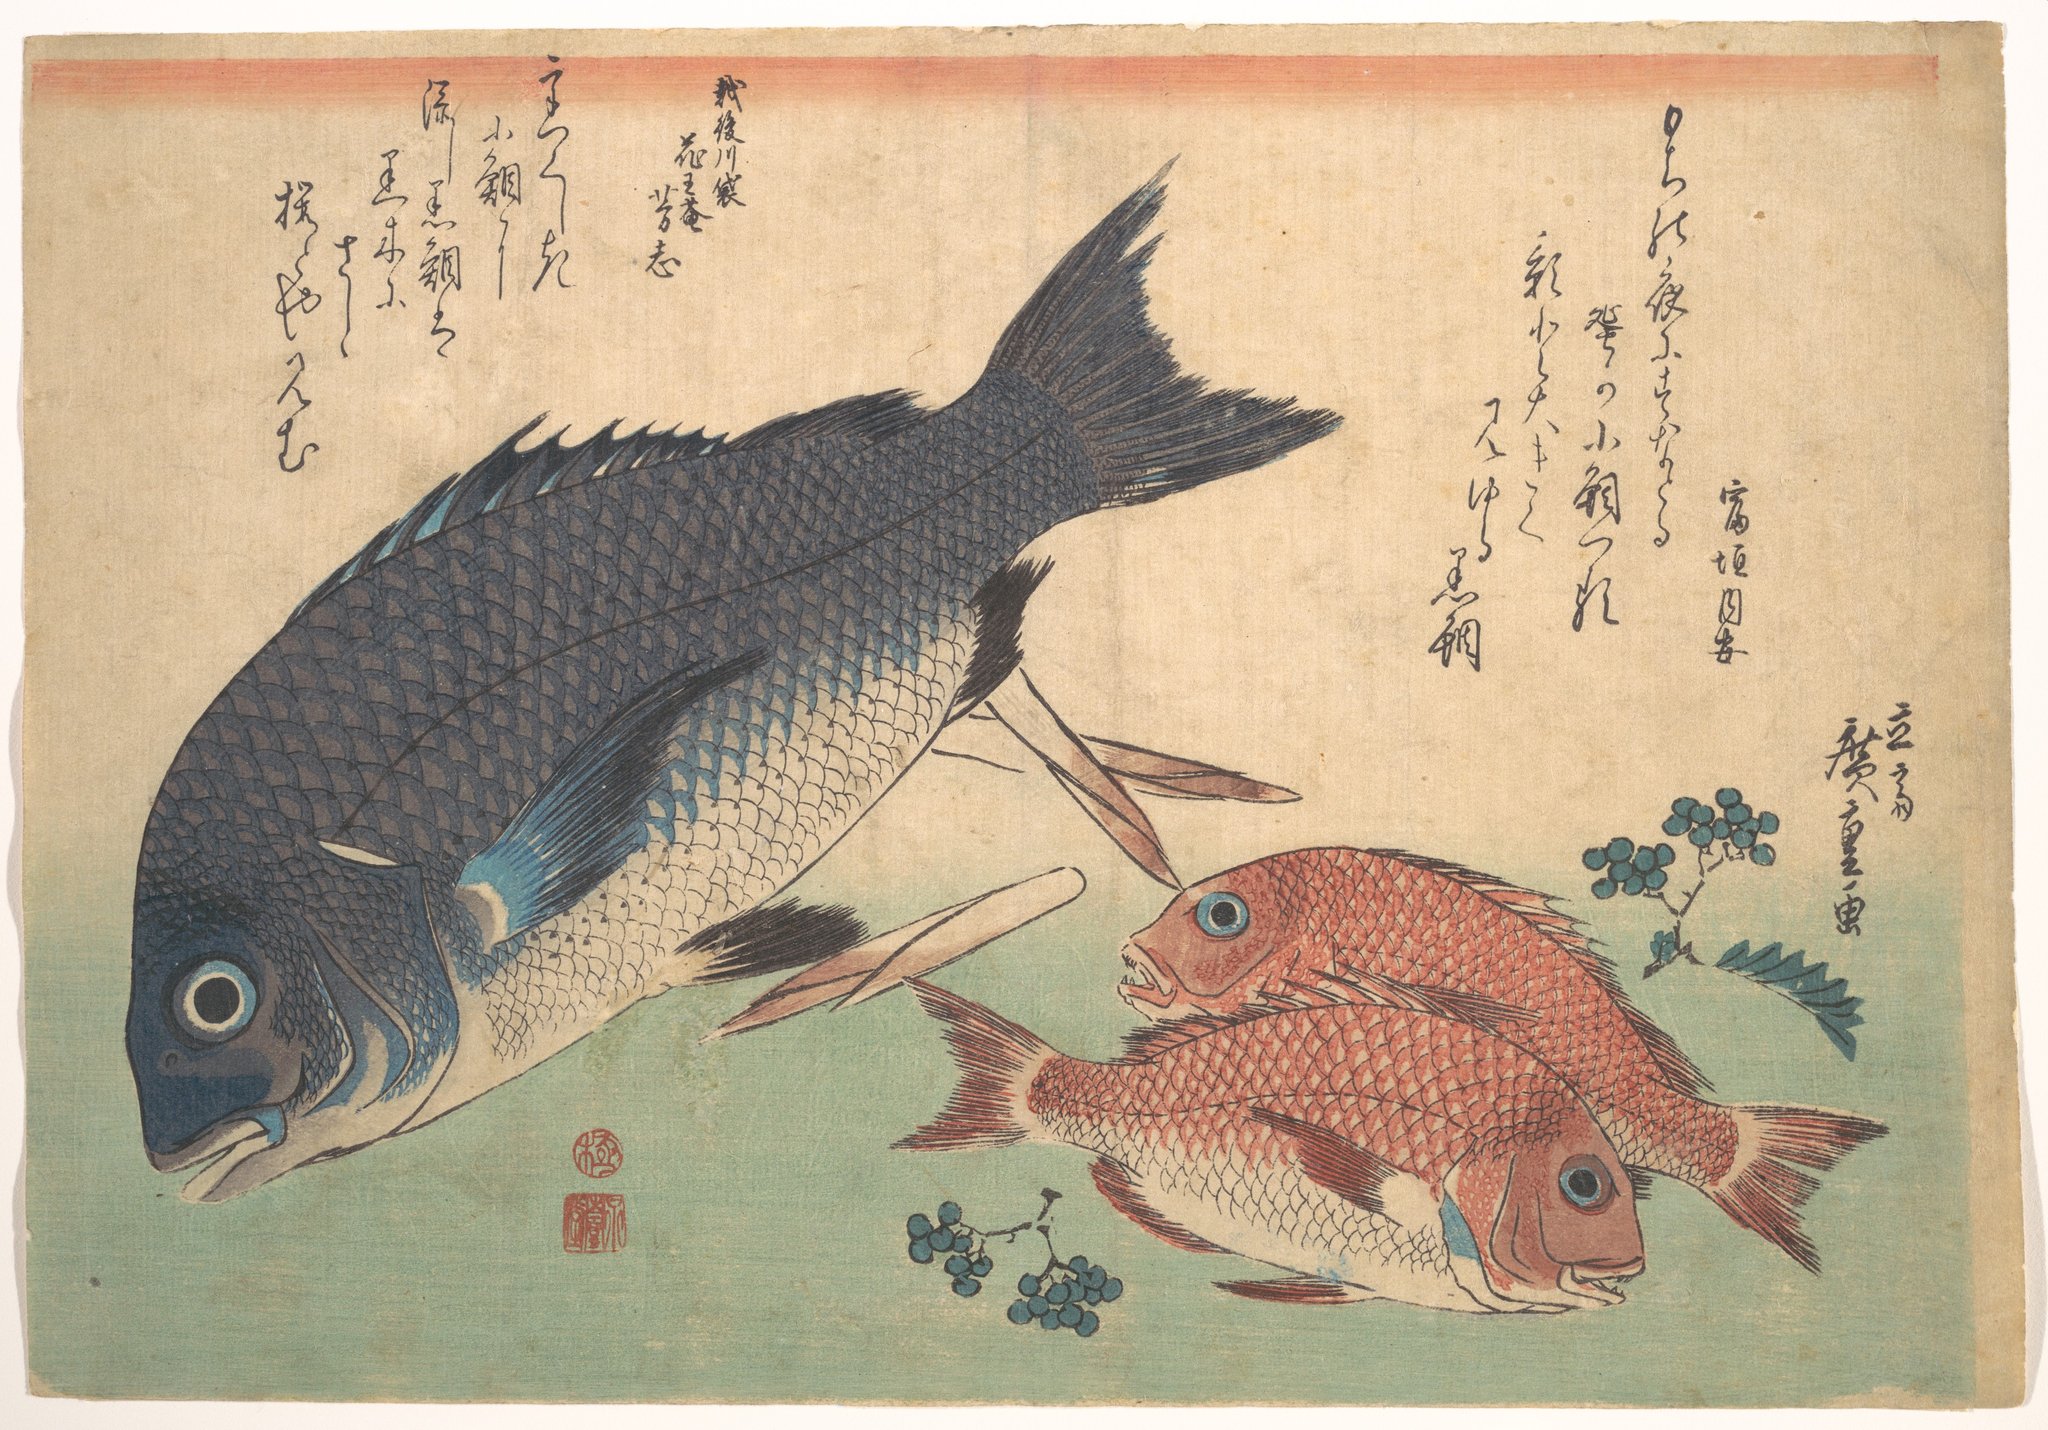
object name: woodblock print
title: Kurodai and Kodai Fish with Bamboo Shoots and Berries, from the series Uozukushi (Every Variety of Fish)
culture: japanese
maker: utagawa hiroshige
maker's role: artist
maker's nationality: japanese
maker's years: 1797-1858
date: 1830-1839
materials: ink, paper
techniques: woodblock print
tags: fish